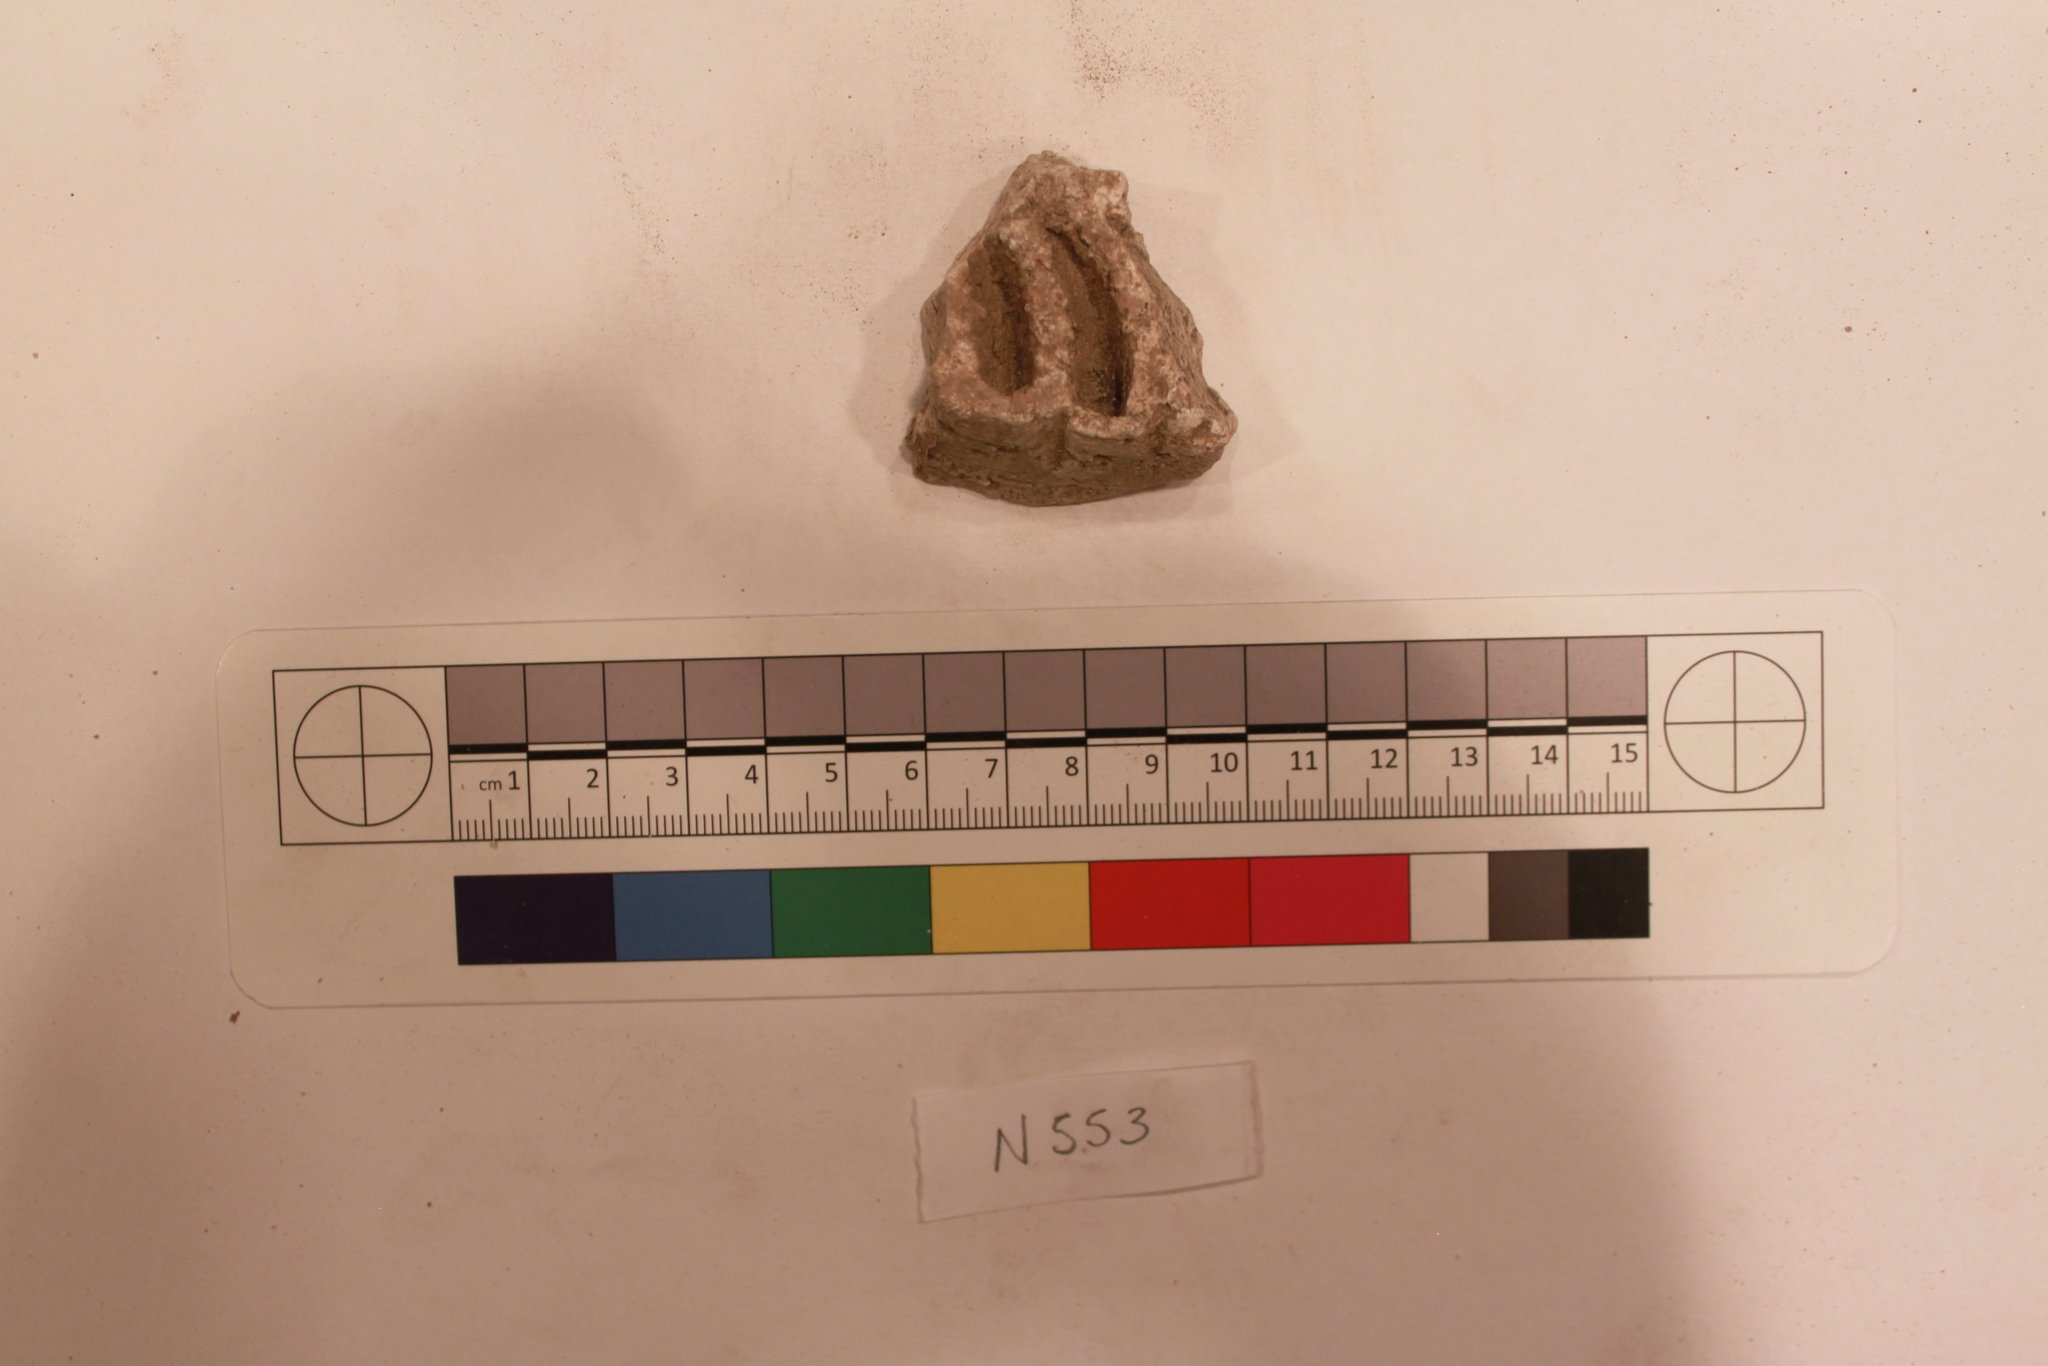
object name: fragment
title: Stucco Fragment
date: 701-1200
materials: plaster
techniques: carving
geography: iran